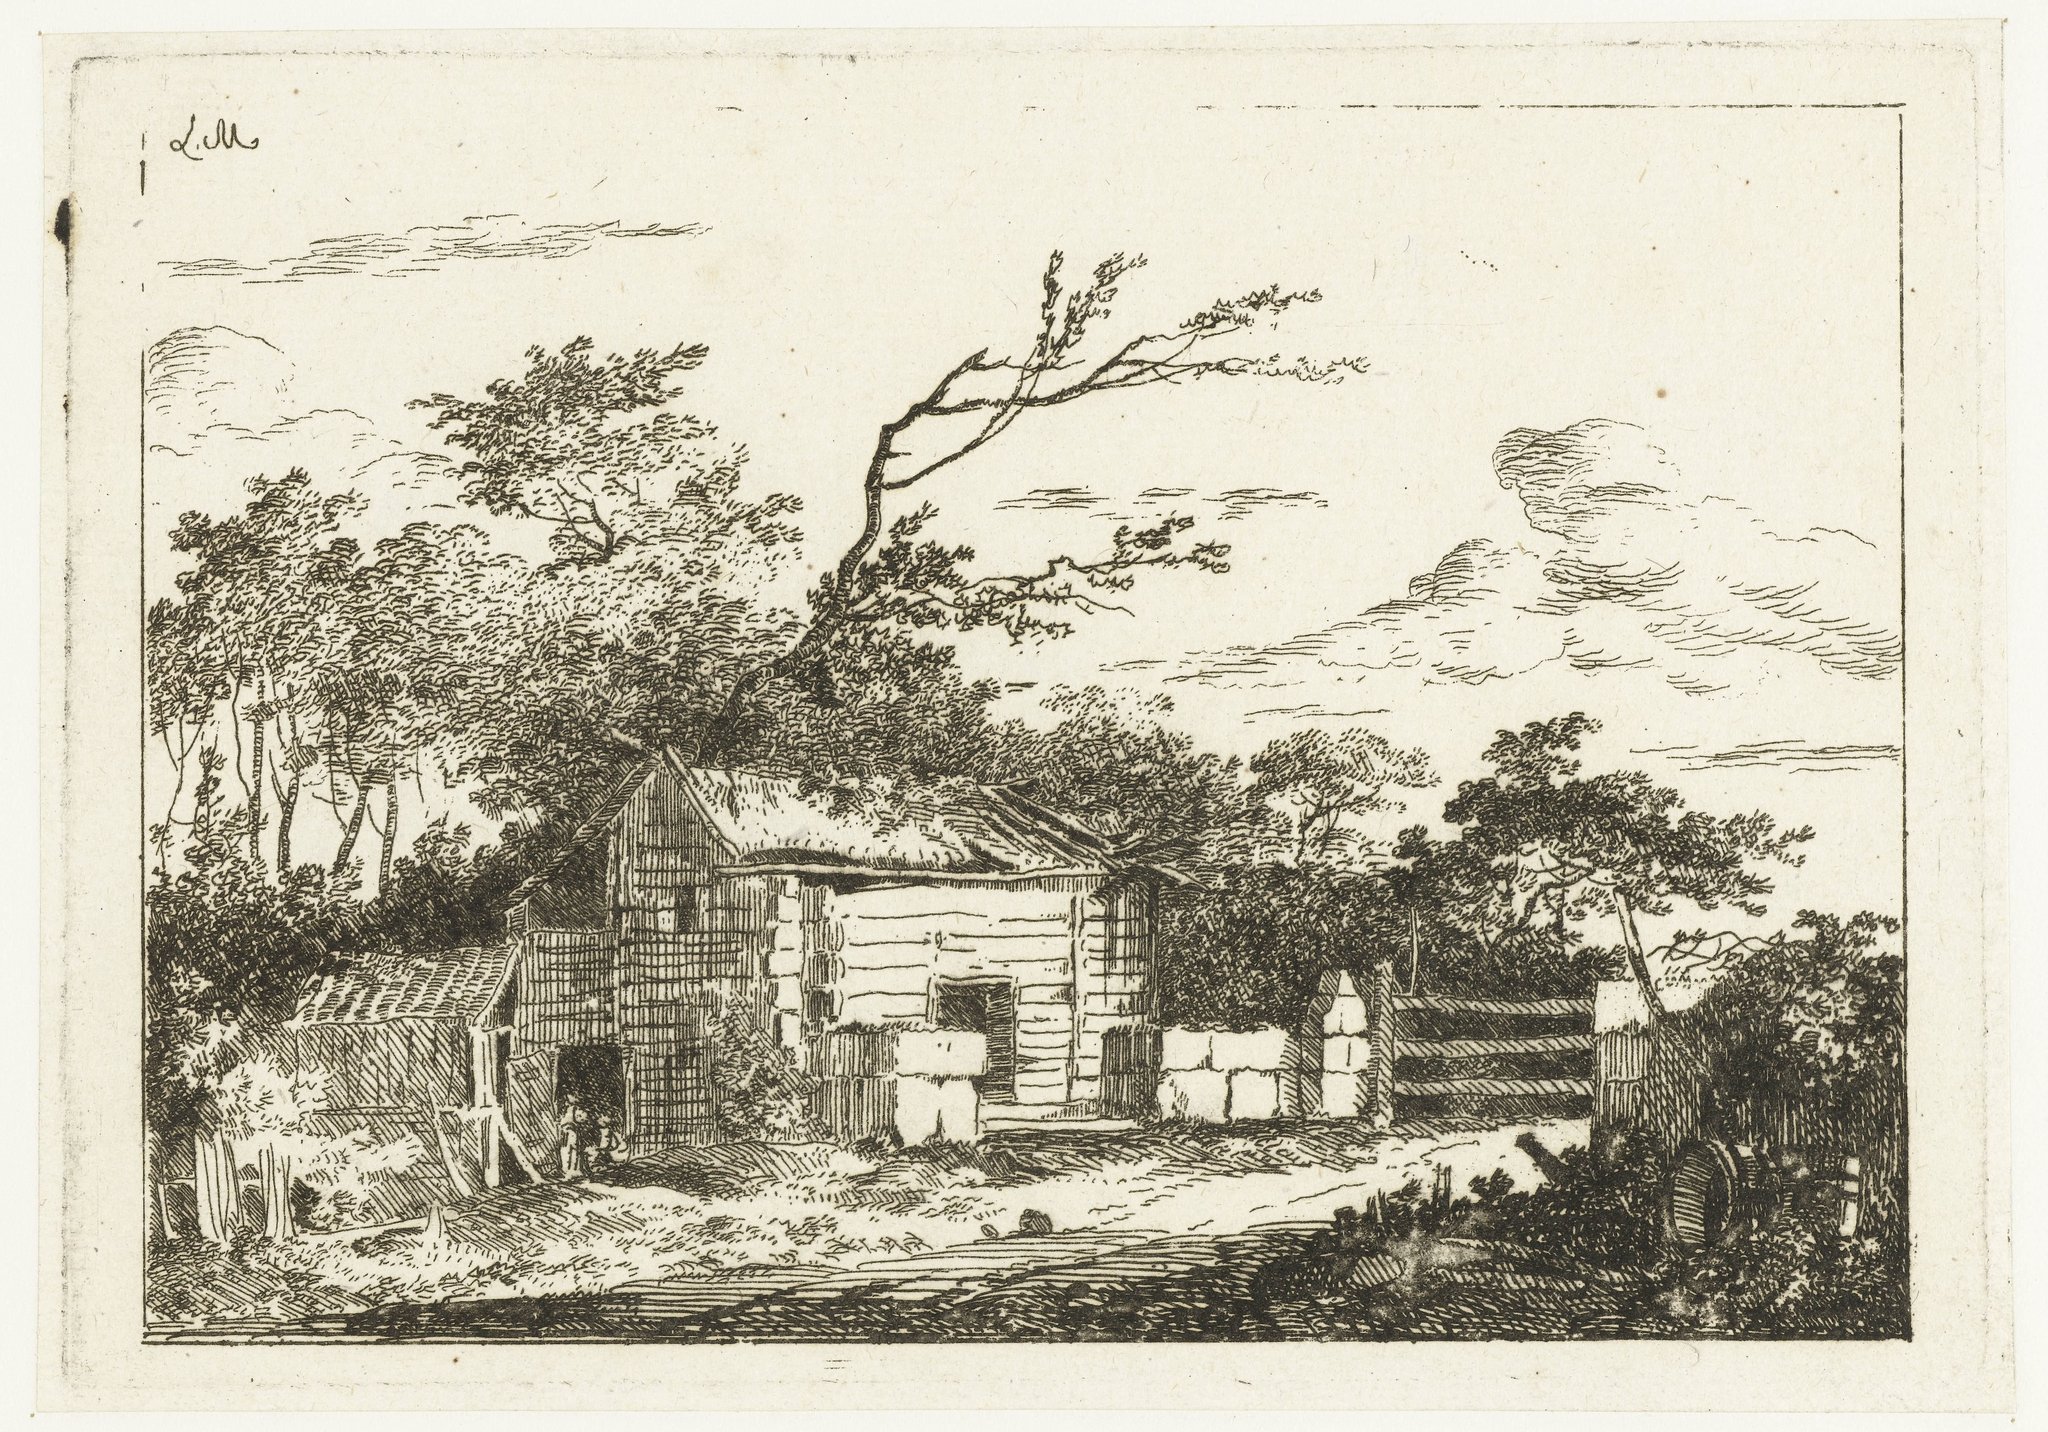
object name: print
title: Huis op een erf met gesloten hek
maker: louis gabriel moreau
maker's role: draughtsman, print maker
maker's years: 1740-1806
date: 1770-1779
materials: paper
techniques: etching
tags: rural housing, e.g. country-house, villa, cottage, gate, entrance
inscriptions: collector's mark: Lugt 2200, collector's mark: Lugt 2228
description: Een huis met twee figuren in een deuropening, op een erf afgesloten door een houten hek.